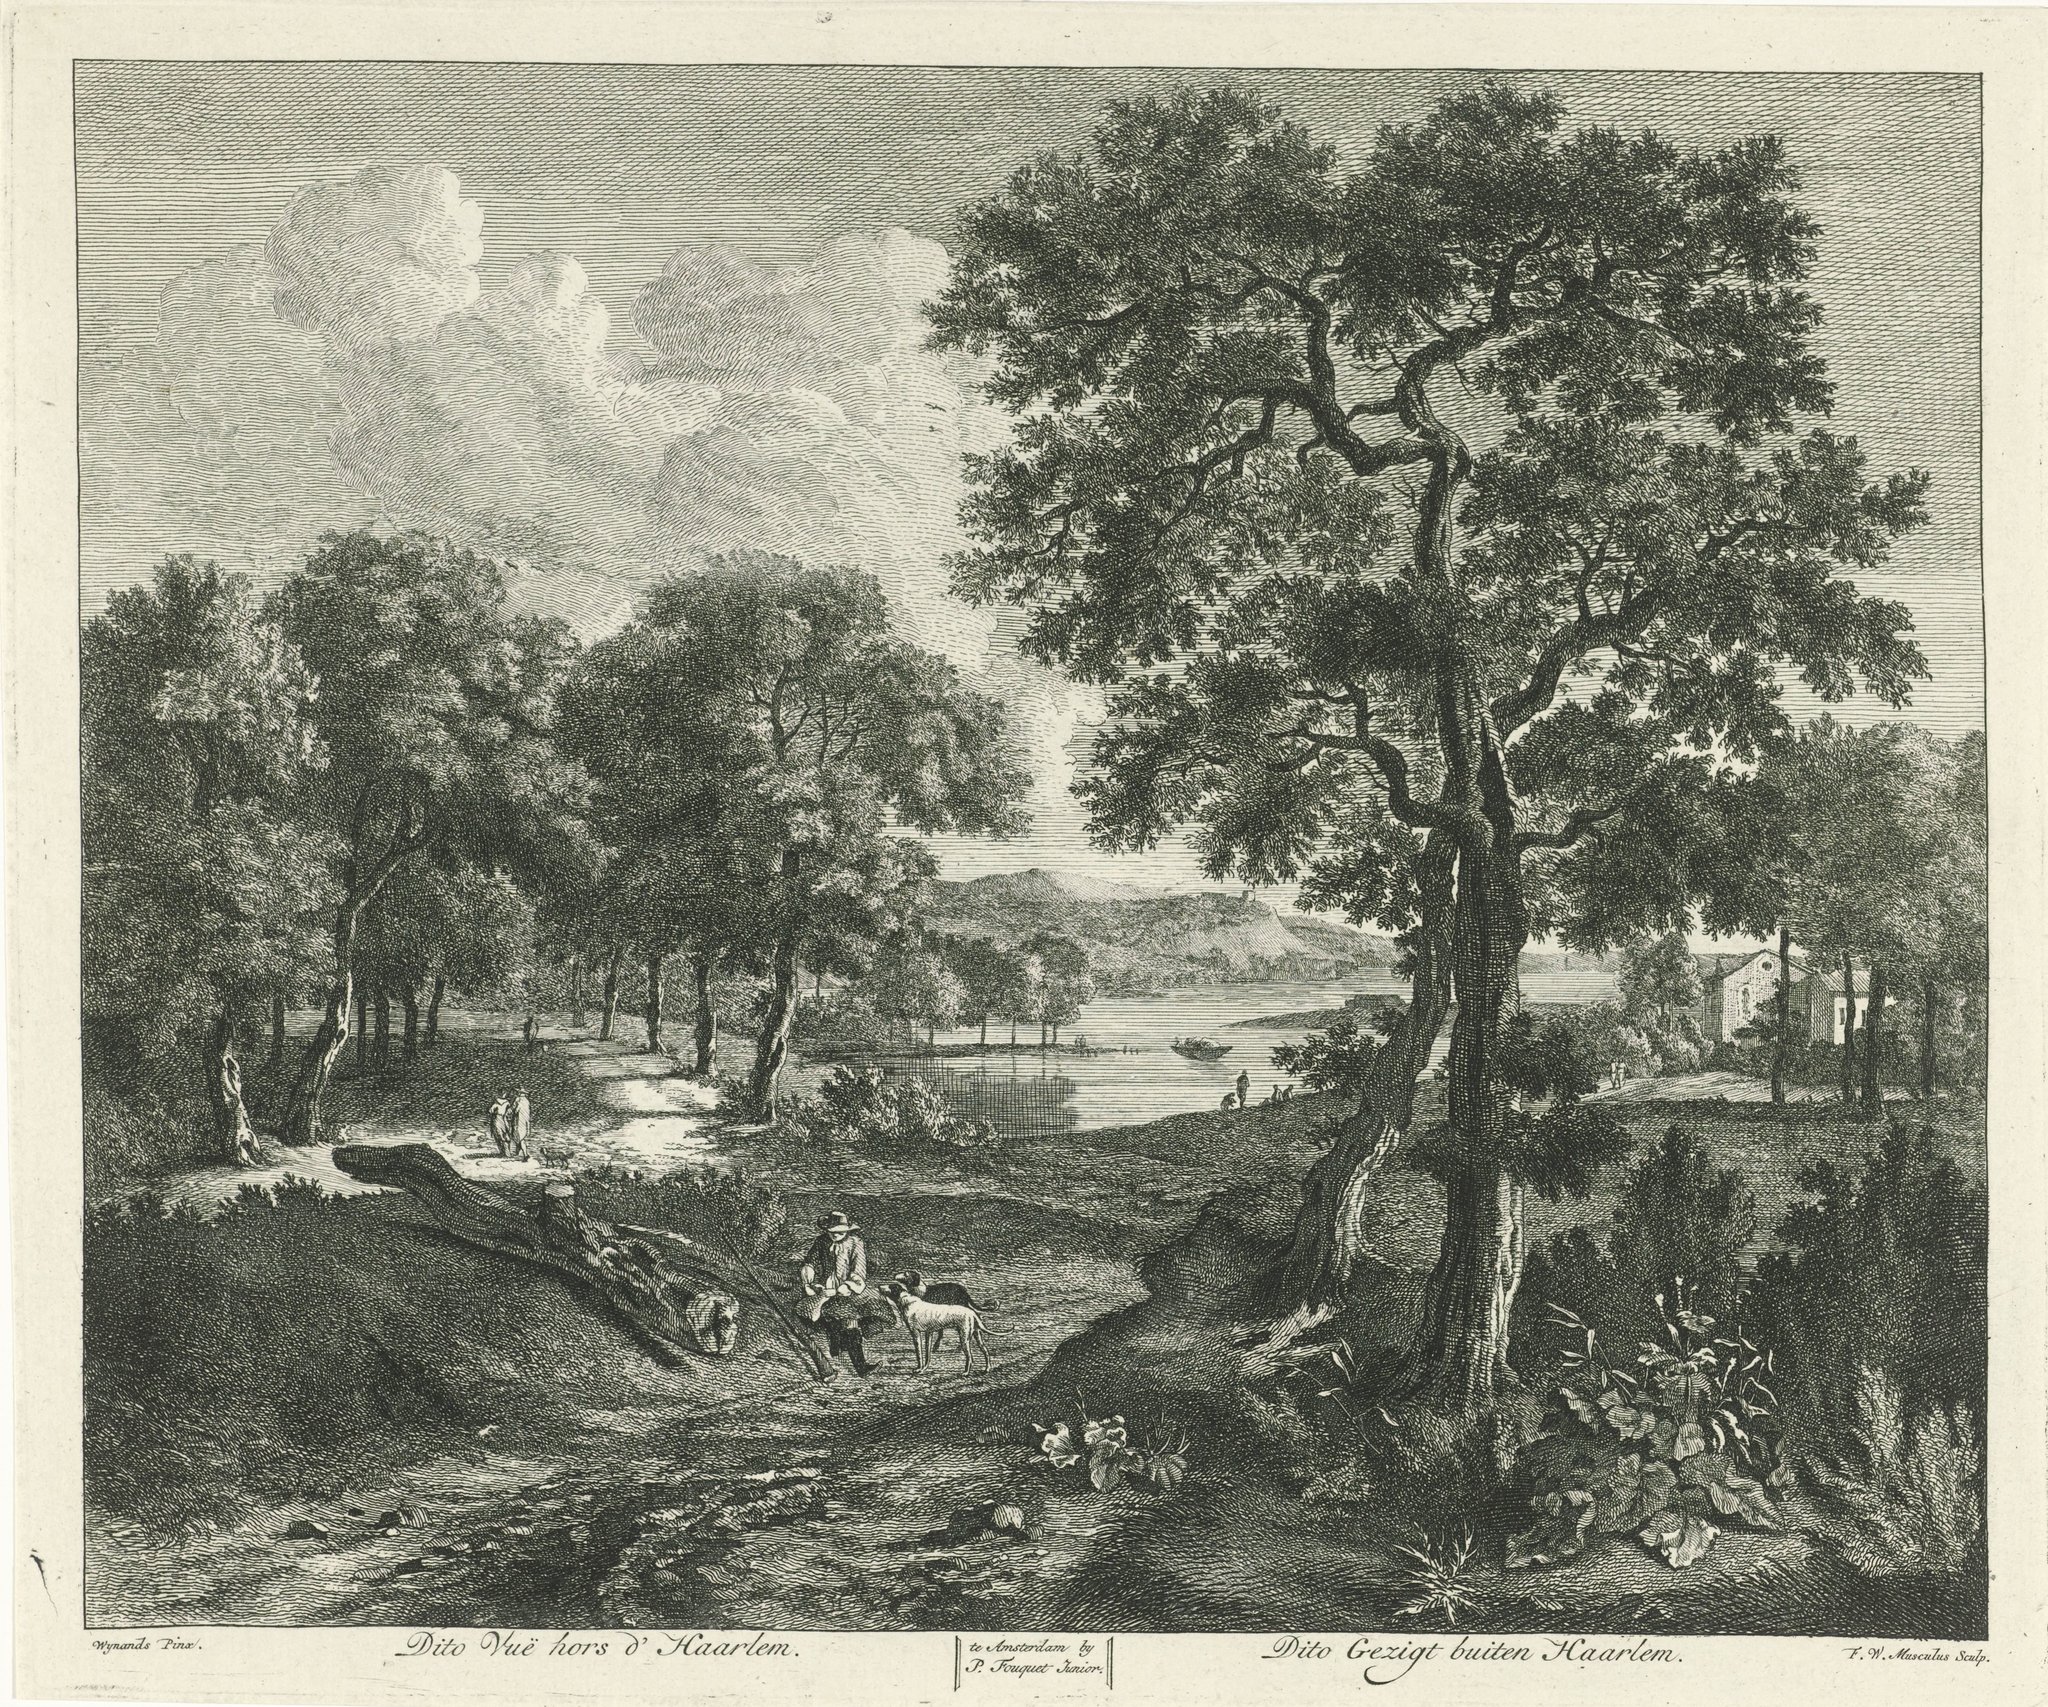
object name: print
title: Duinlandschap buiten Haarlem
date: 1760-1796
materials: paper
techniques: engraving, etching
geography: amsterdam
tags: hunting dogs, hunter, dunes (sea not visible); in the dunes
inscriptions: collector's mark: Lugt 2228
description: Duinlandschap buiten Haarlem met een meer op de achtergrond. Op de voorgrond een rustende jager met twee jachthonden.